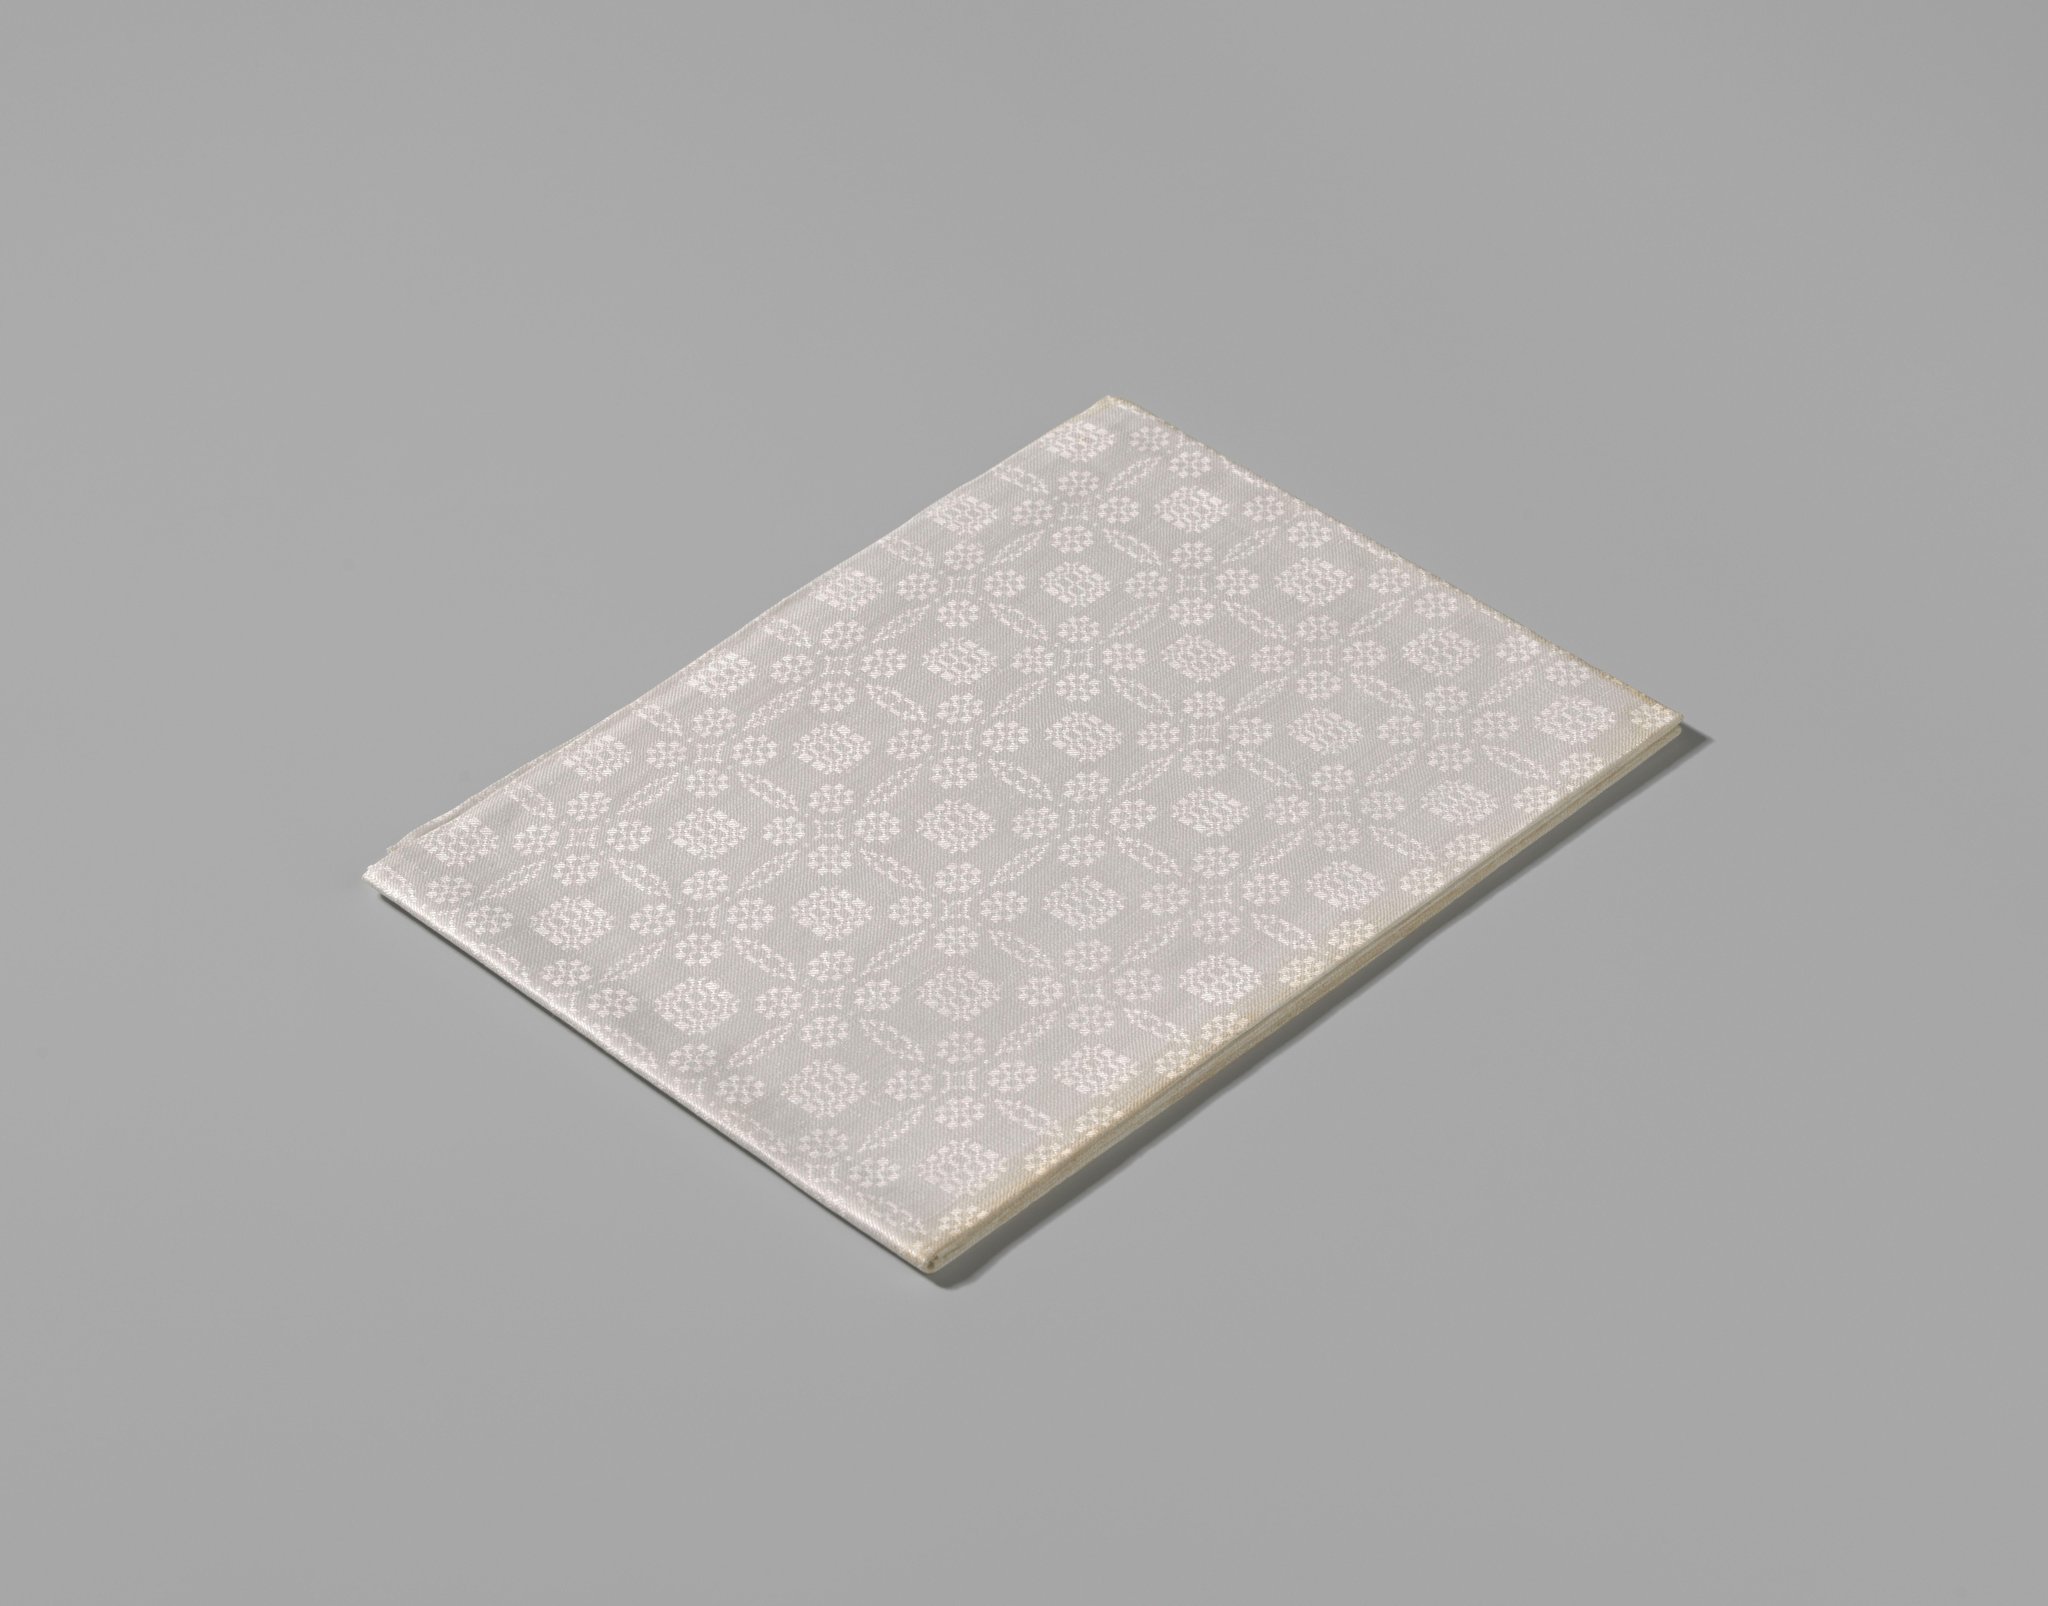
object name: napkin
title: Servet van wit linnen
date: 1650-1675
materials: linen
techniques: peeled fabric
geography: northern netherlands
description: Wit linnen servet, pellen in keperbinding, gemerkt kroon RR WO 40 en 6.